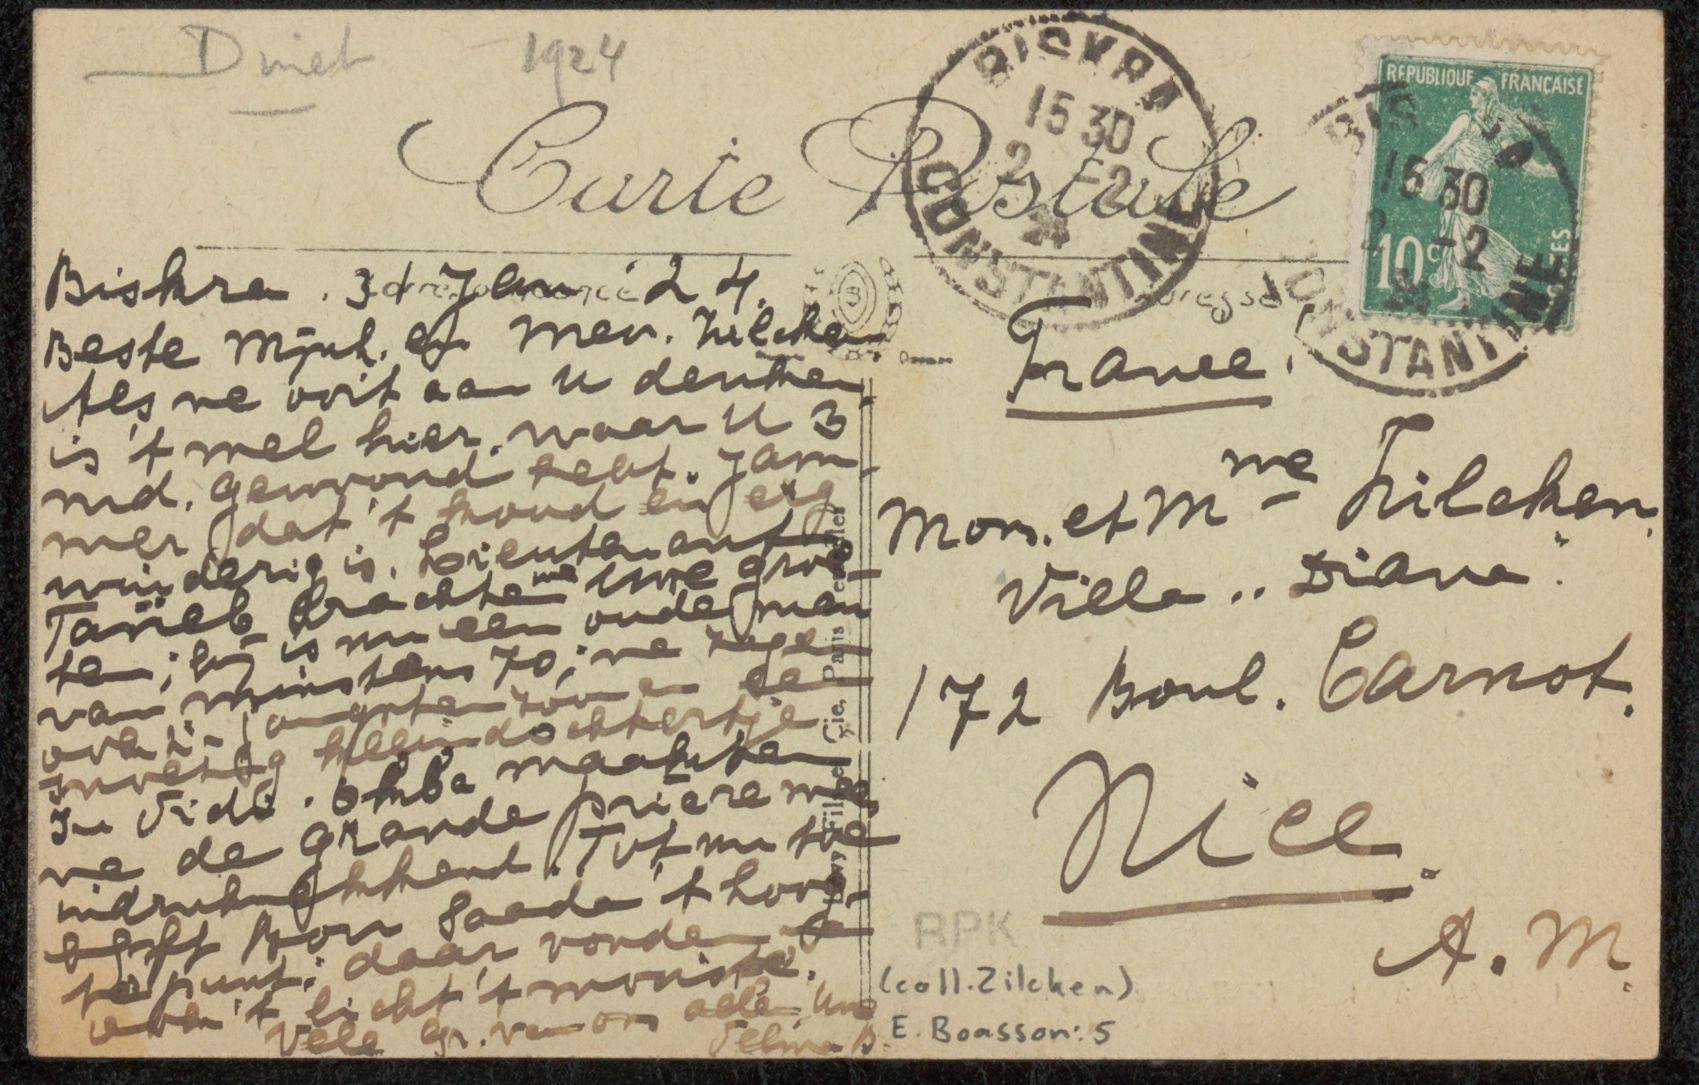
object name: ansichtkaart, prentbriefkaart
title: Prentbriefkaart aan Philip Zilcken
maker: selma boasson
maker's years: 1884-1924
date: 1924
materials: cardboard, ink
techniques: photograph, pen, writing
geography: biskra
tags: painter, draughtsman, philip zilcken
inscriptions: collector's mark: ‘RPK’